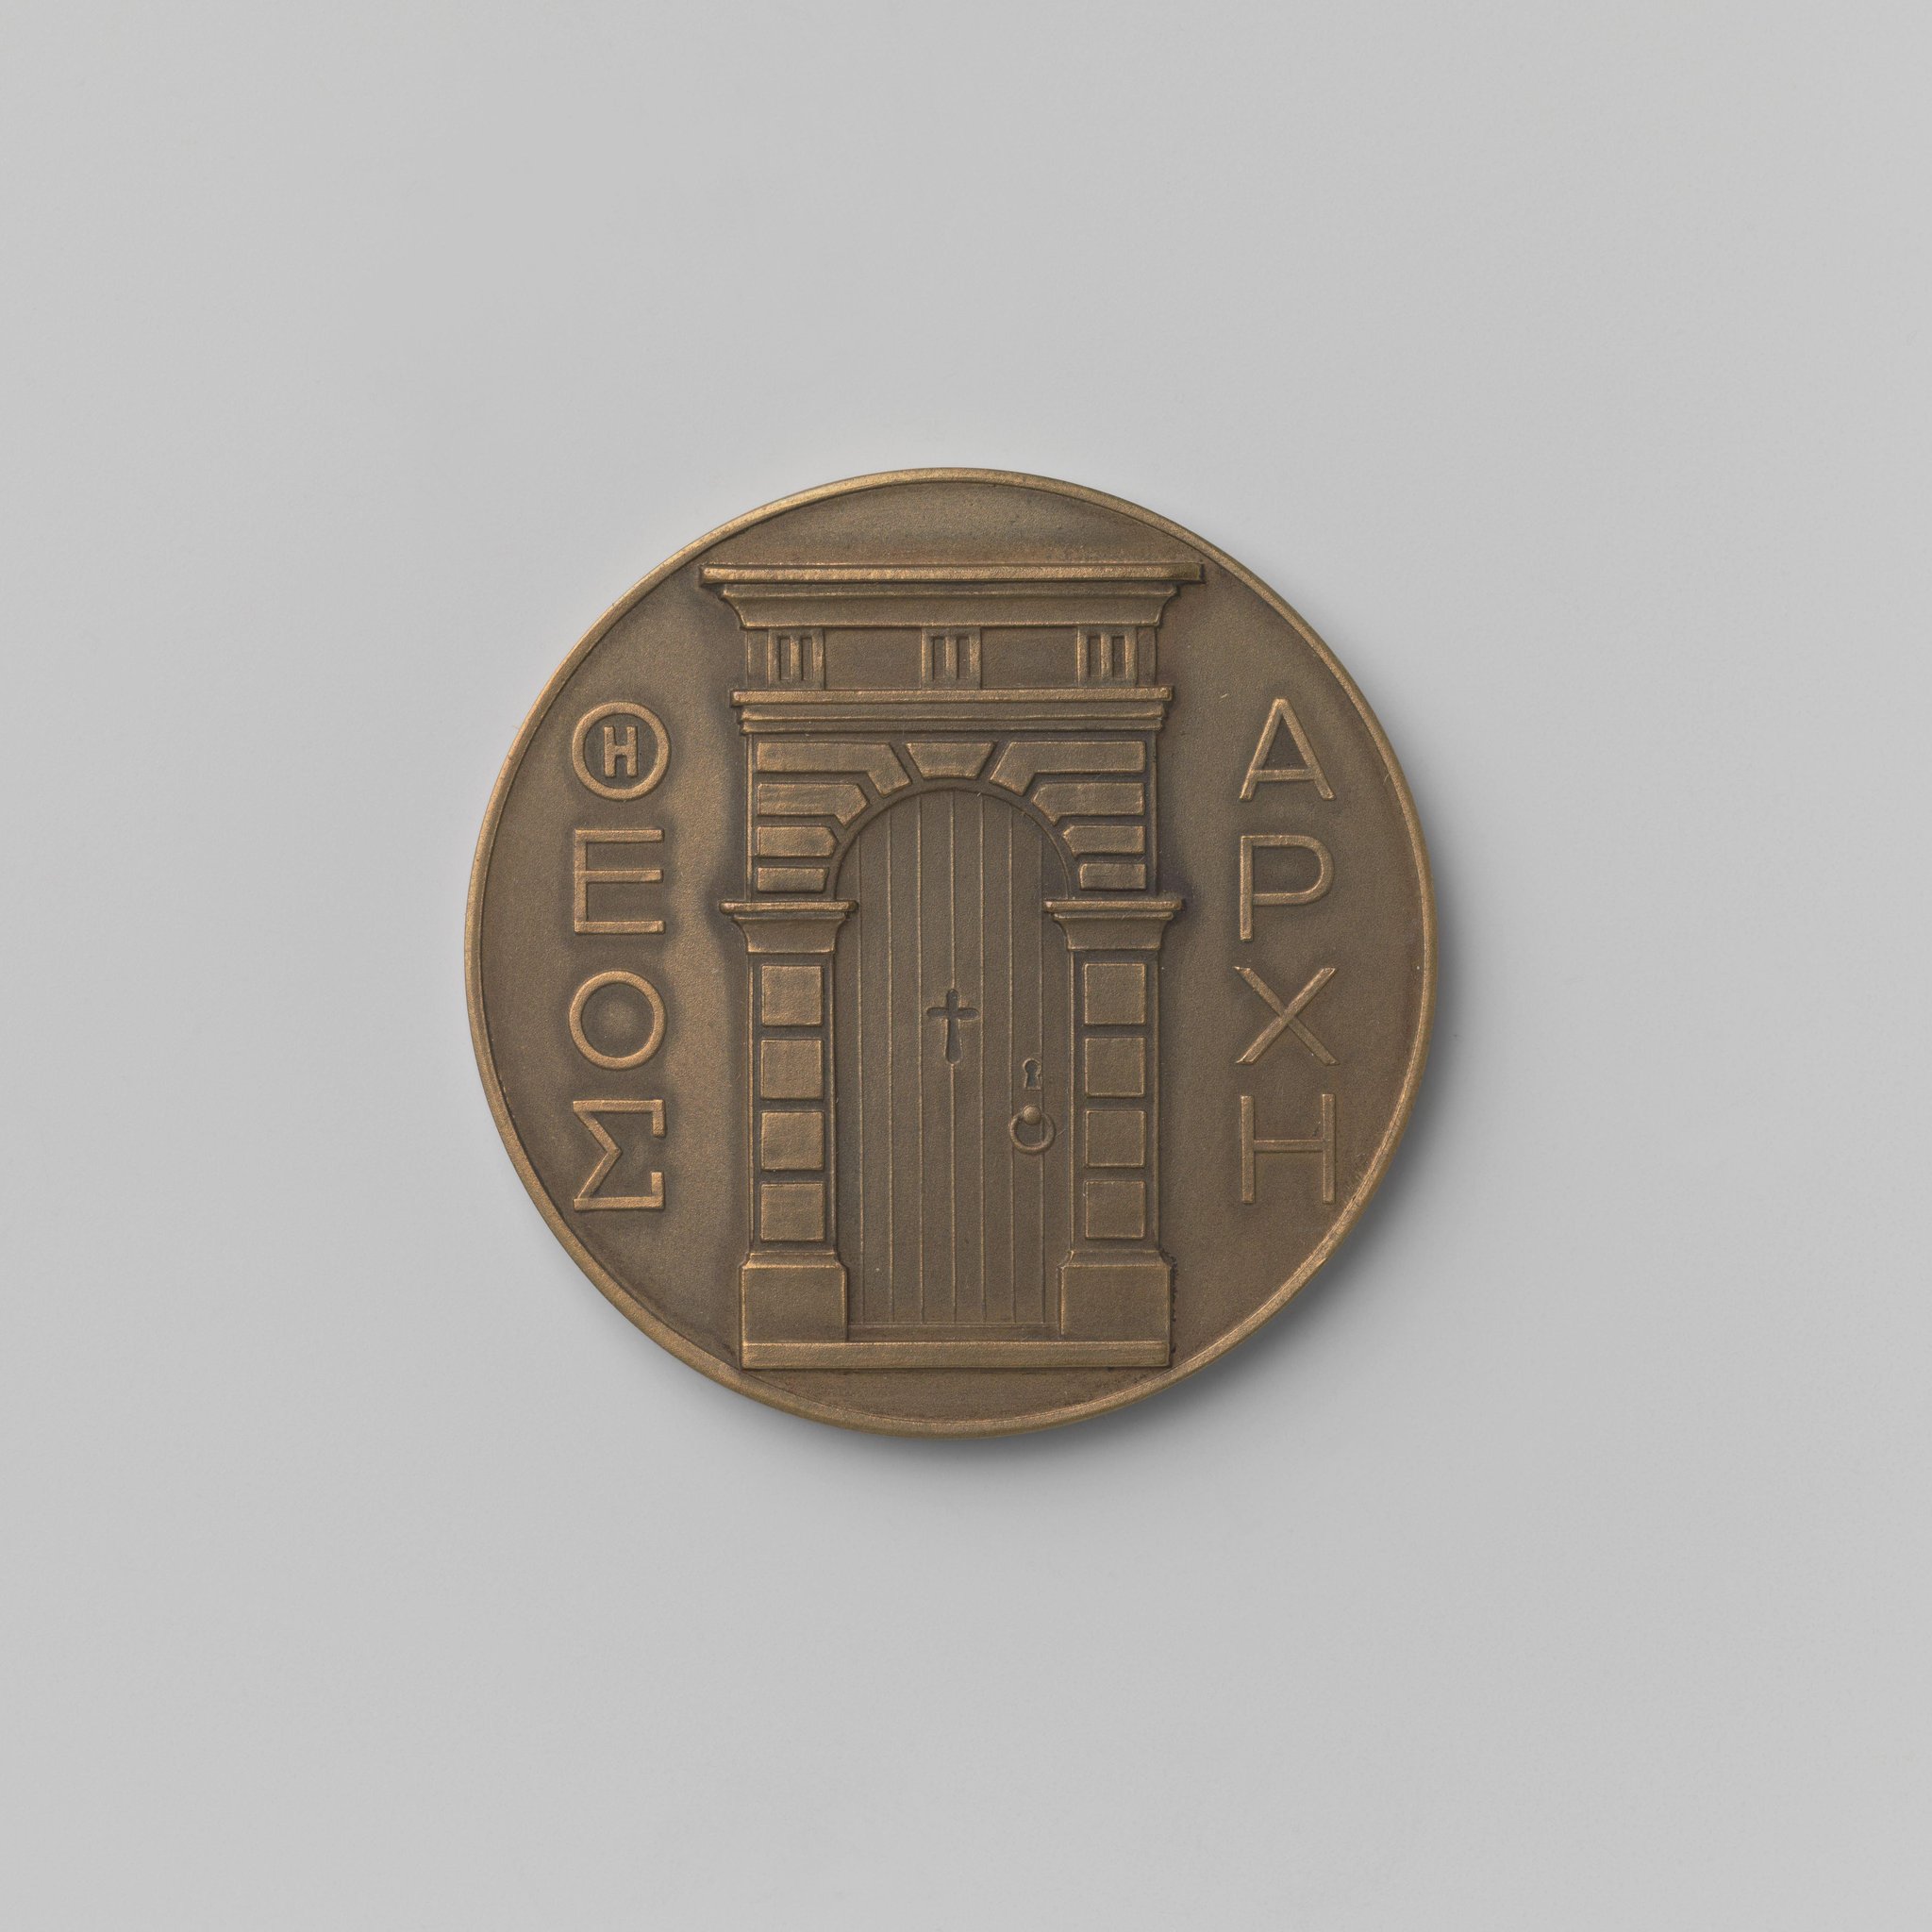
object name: history medal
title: Vijfentwintigjarig bestaan van het gymnasium te Alkmaar 1929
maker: a köhler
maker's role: modelleur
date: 1929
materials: bronze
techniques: striking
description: Bronzen penning, op de voorzijde een poort tussen twee woorden in griekse letters, op de keerzijde zes regels tekst onder een Alkmaars wapenschild.